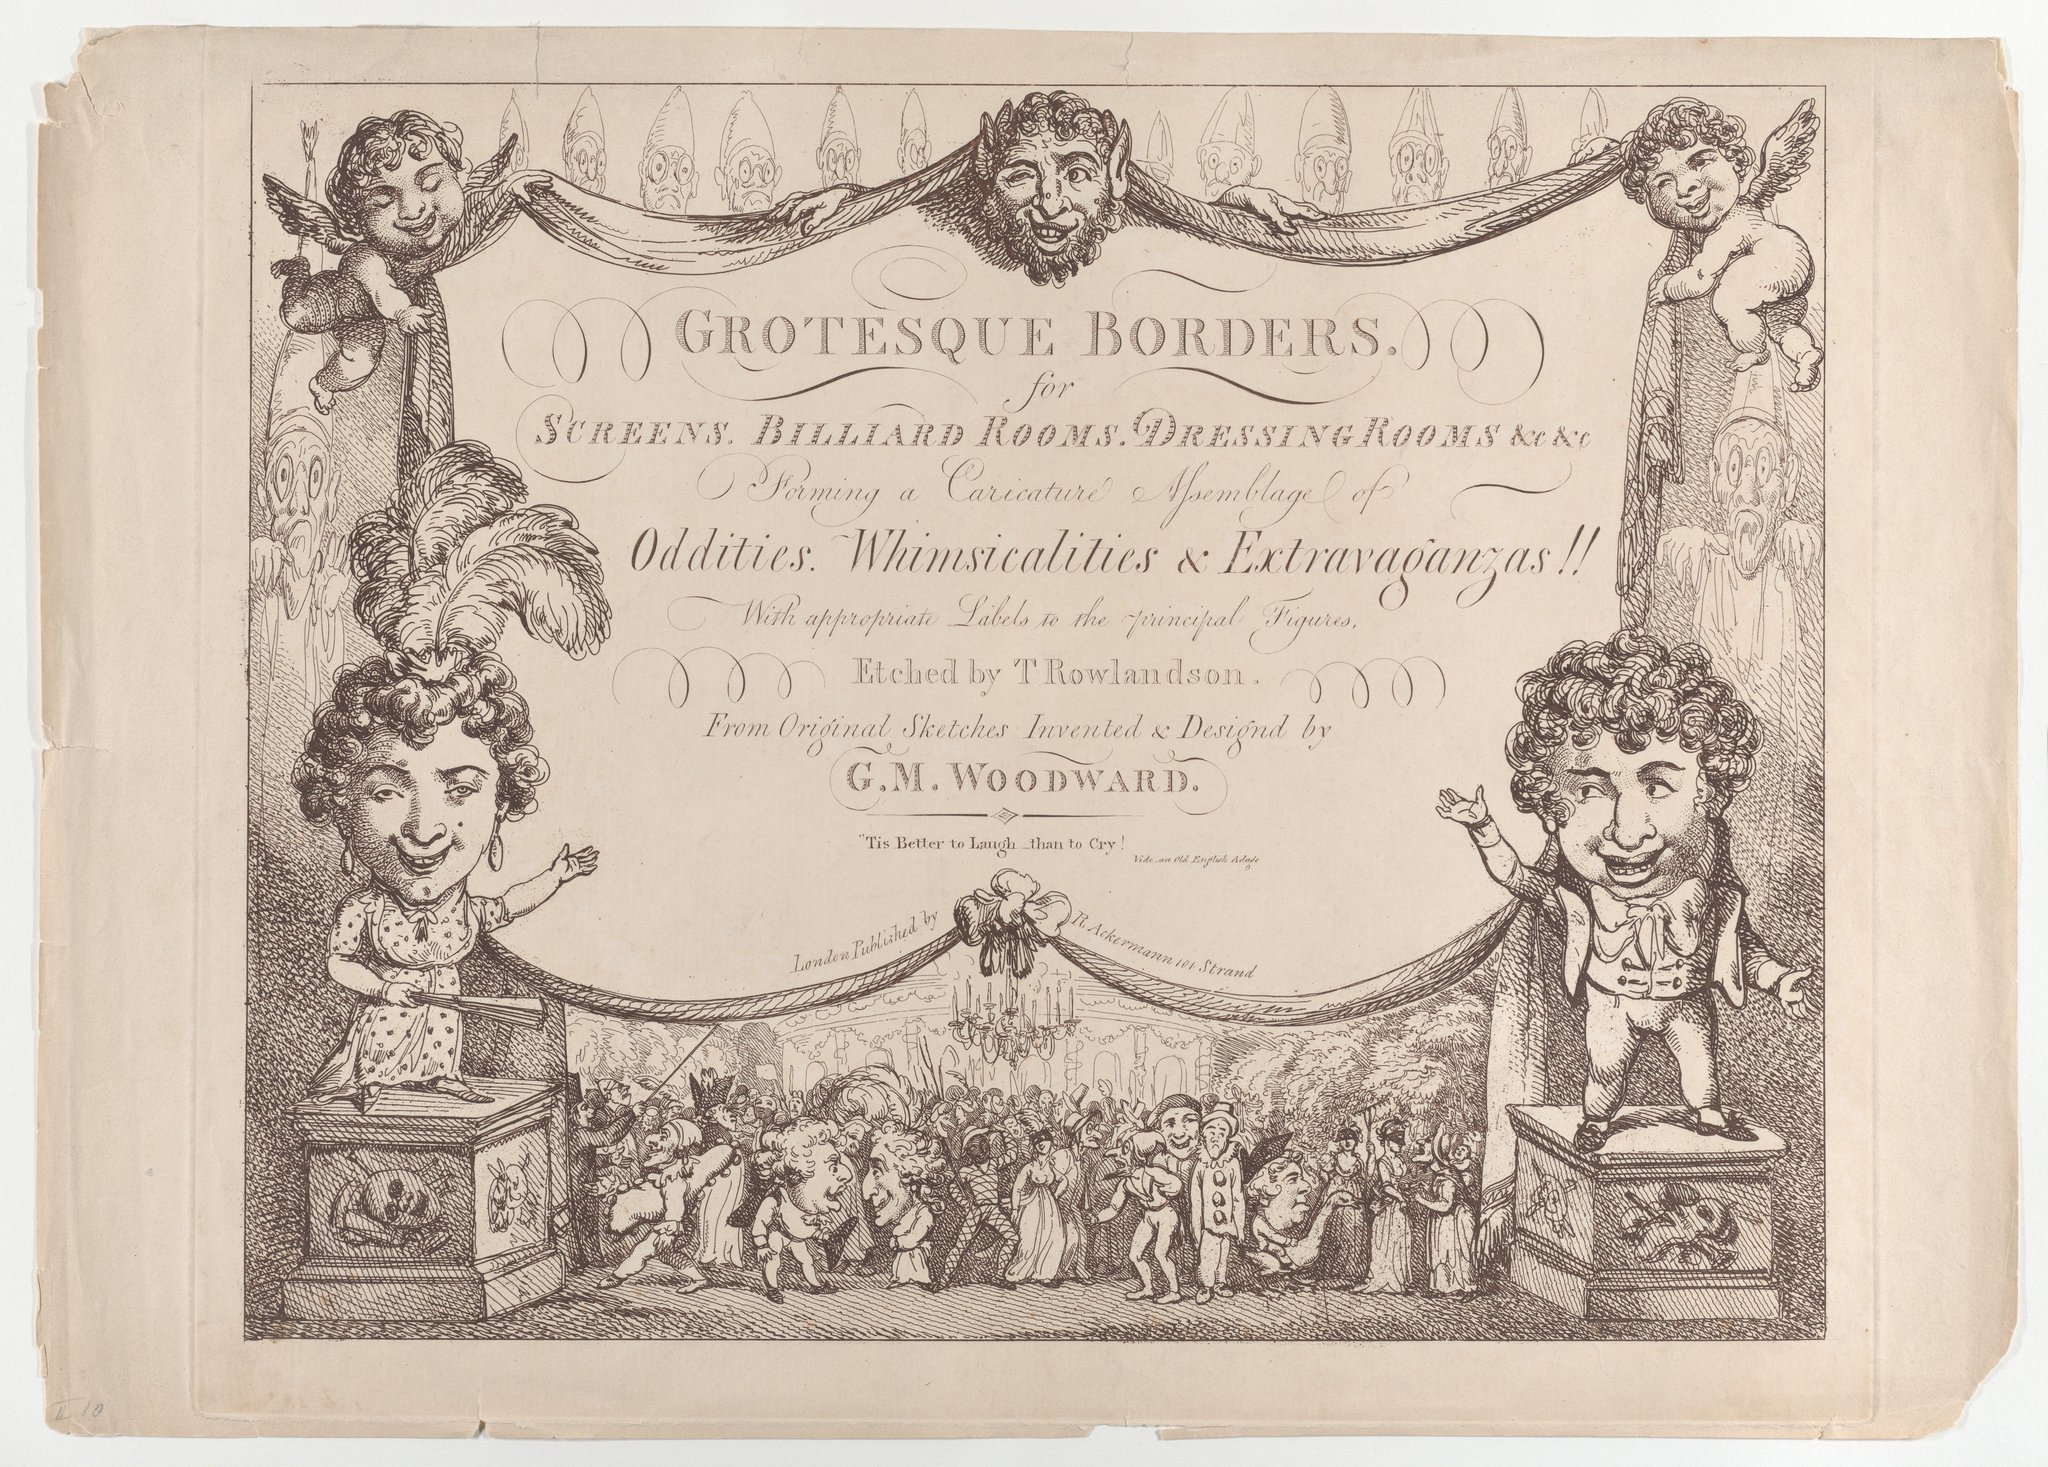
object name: print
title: Grotesque Borders for Screens, Billiard Rooms, Dressing Rooms, &c &c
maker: thomas rowlandson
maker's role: artist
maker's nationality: british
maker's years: 1757-1827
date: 1799-1800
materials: ink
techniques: etching